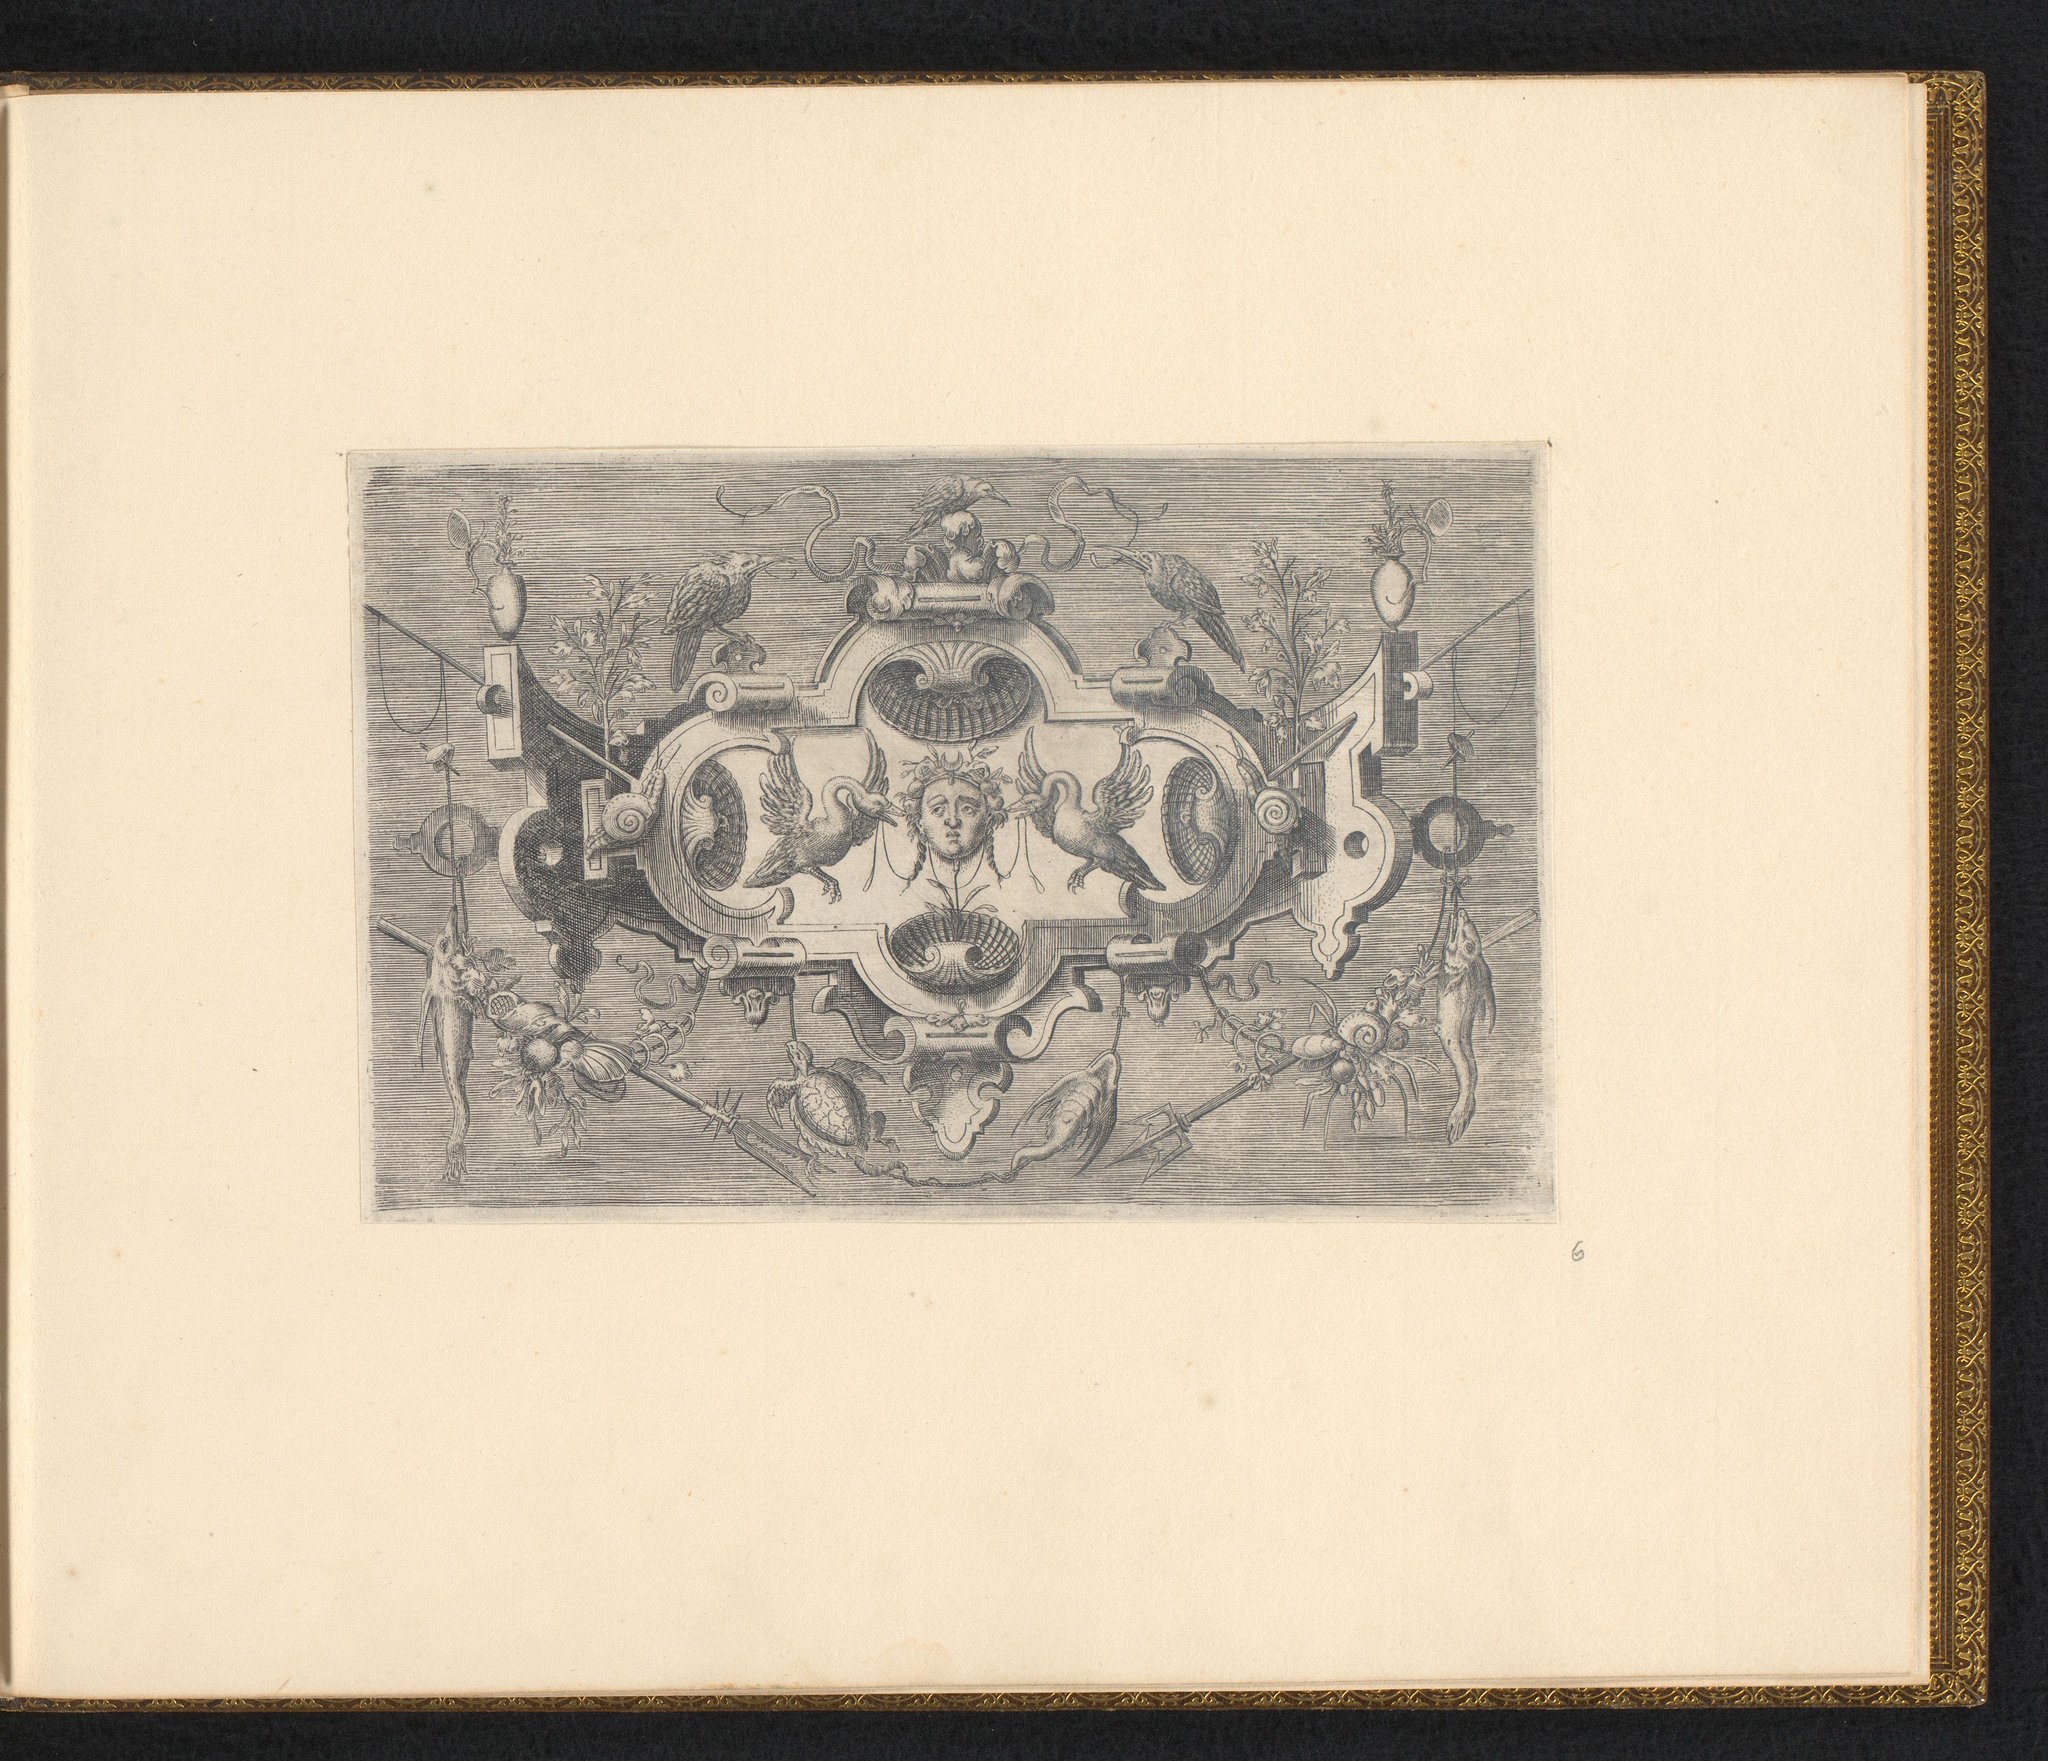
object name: print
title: Veelderhande cierlijcke compertementen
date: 1564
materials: paper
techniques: engraving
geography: antwerp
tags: tortoises, turtles, scrollwork, strapwork ~ ornament, water-birds: swan, birds, fishes, scallop, shell ~ ornament, ornament ~ cartouche, mask, mascaron ~ ornament, attributes of neptune: trident, molluscs: snail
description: Cartouche met vier schelpen en een mascaron geflankeerd door twee zwanen, in een omlijsting van rolwerk. Daarop twee slakken. Op de cartouche twee vazen en drie vogels. Aan de cartouche hangen een tweetand en een drietand vissen en een schildpad. De prent maakt deel uit van een album.